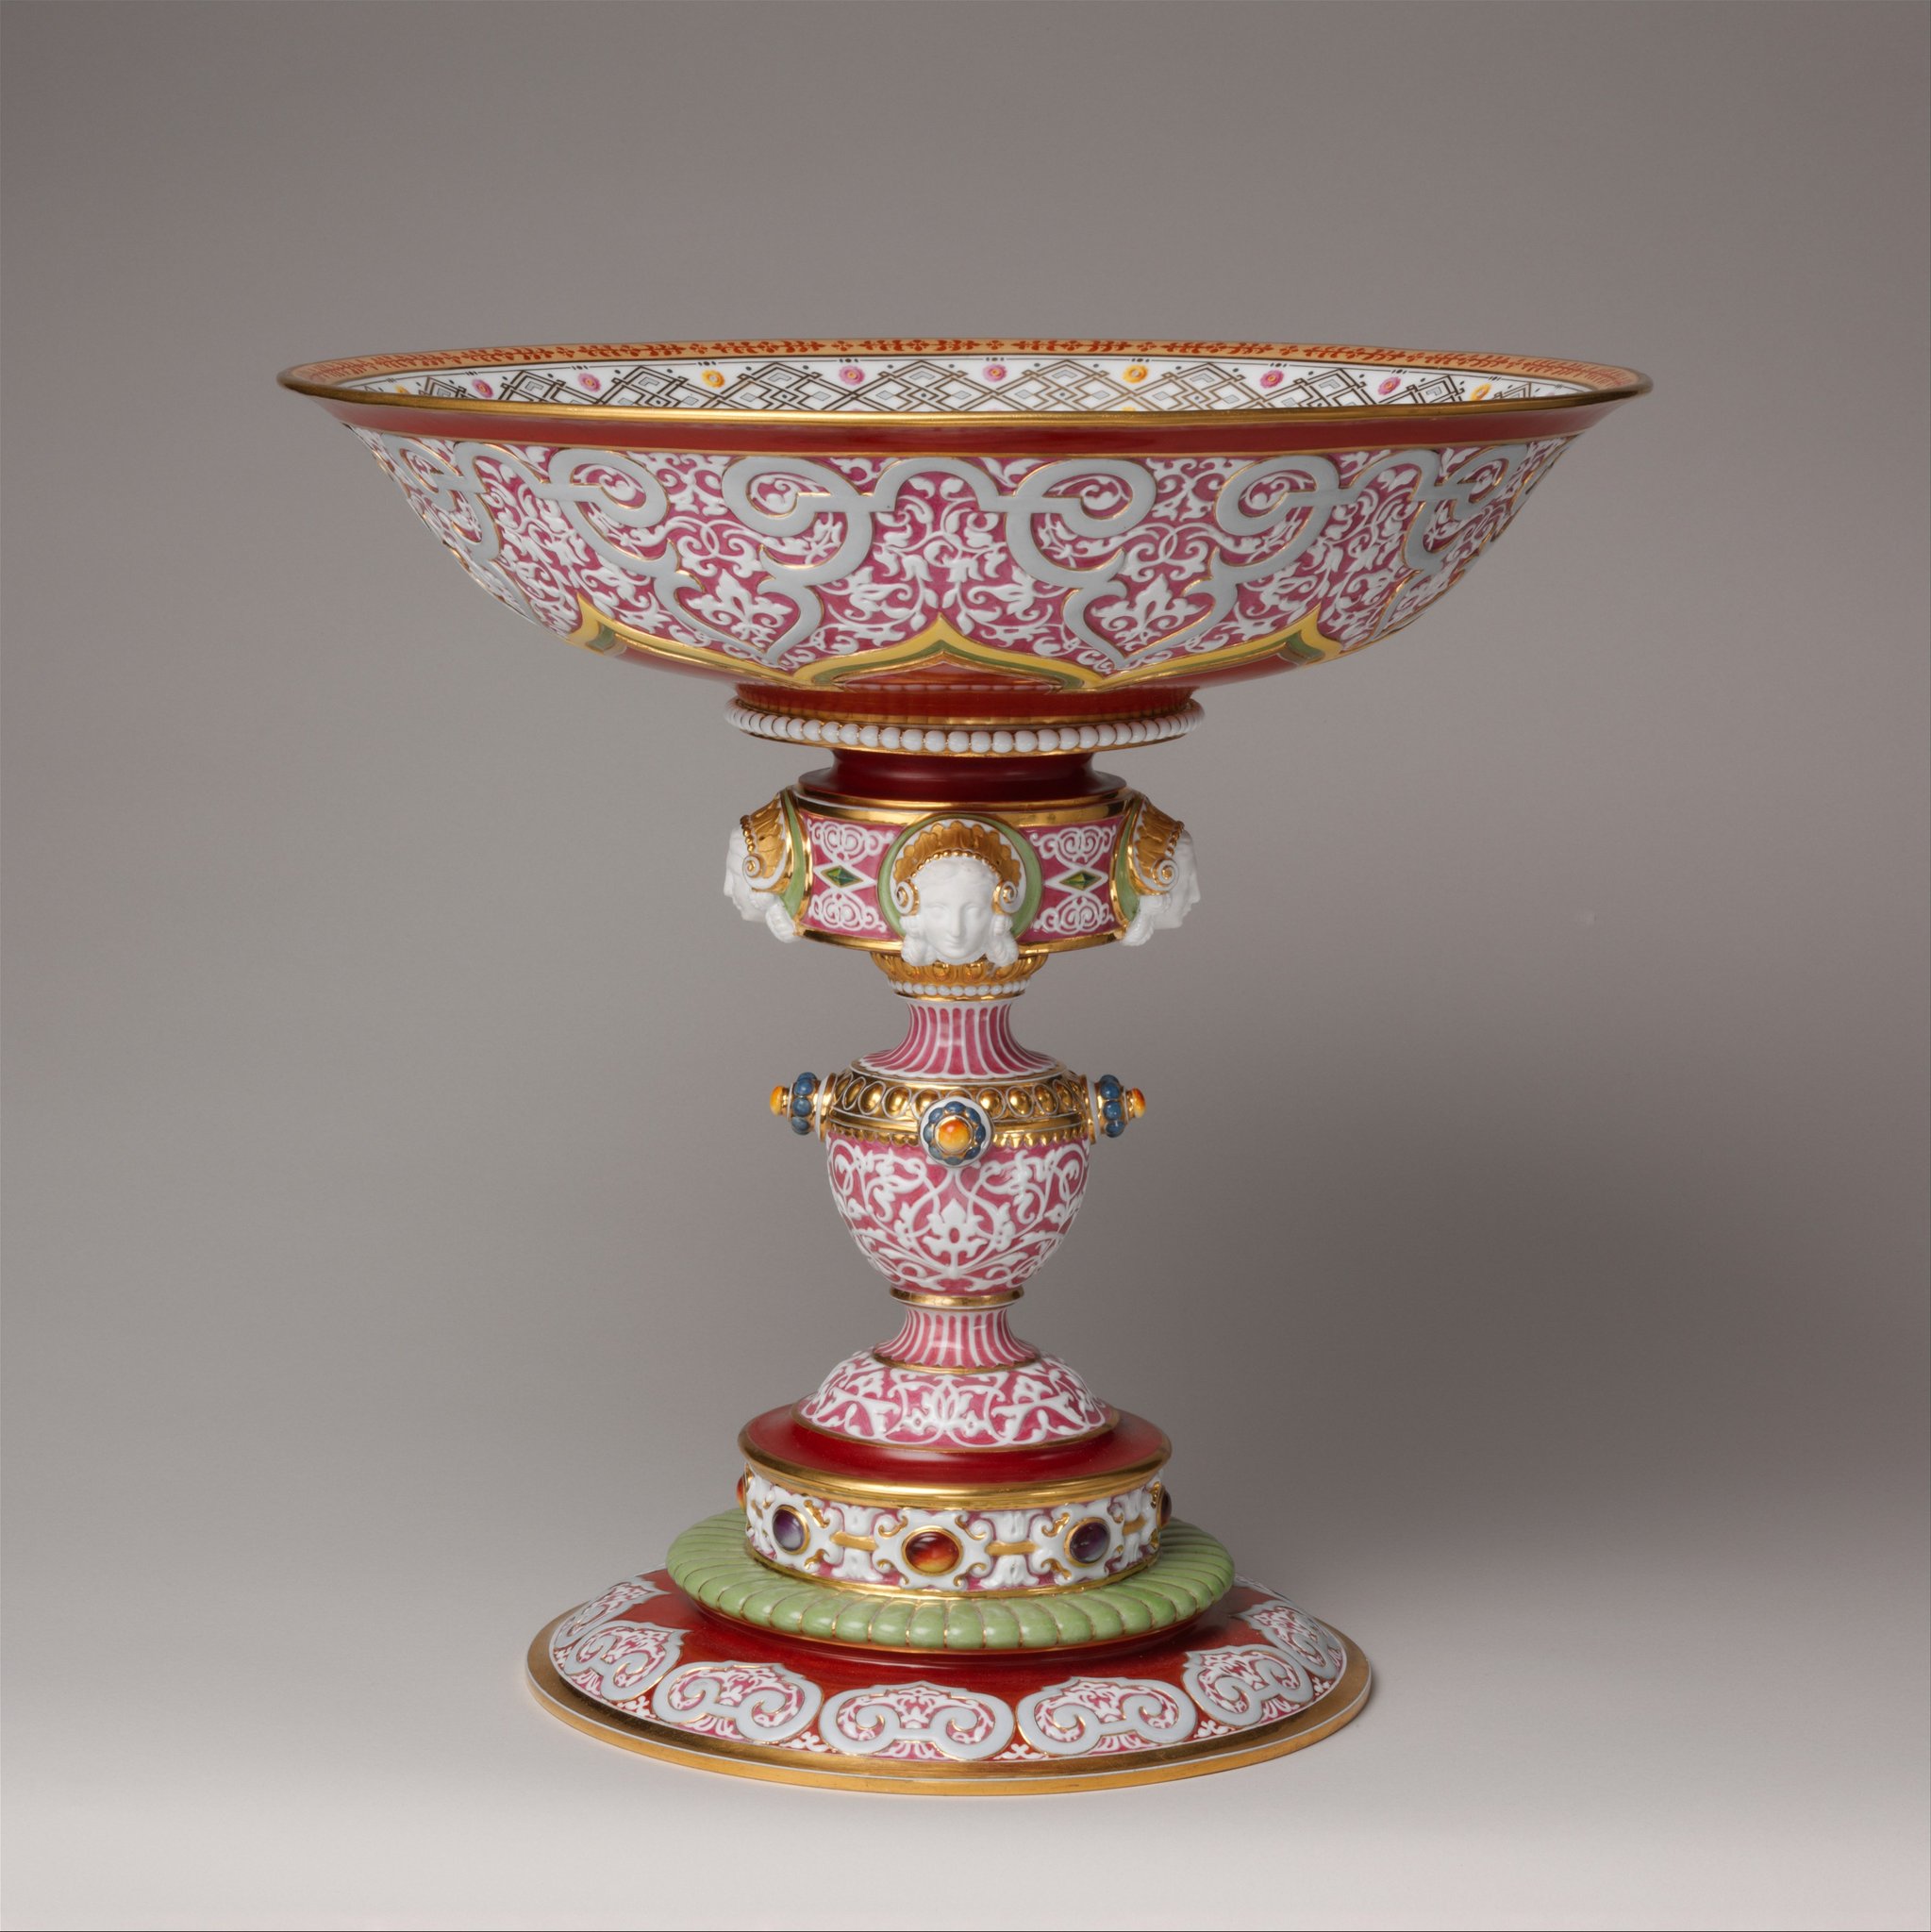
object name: standing cup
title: Standing cup (coupe Chenavard)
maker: sèvres manufactory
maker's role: manufactory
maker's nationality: french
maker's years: 1740-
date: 1837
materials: hard paste porcelain